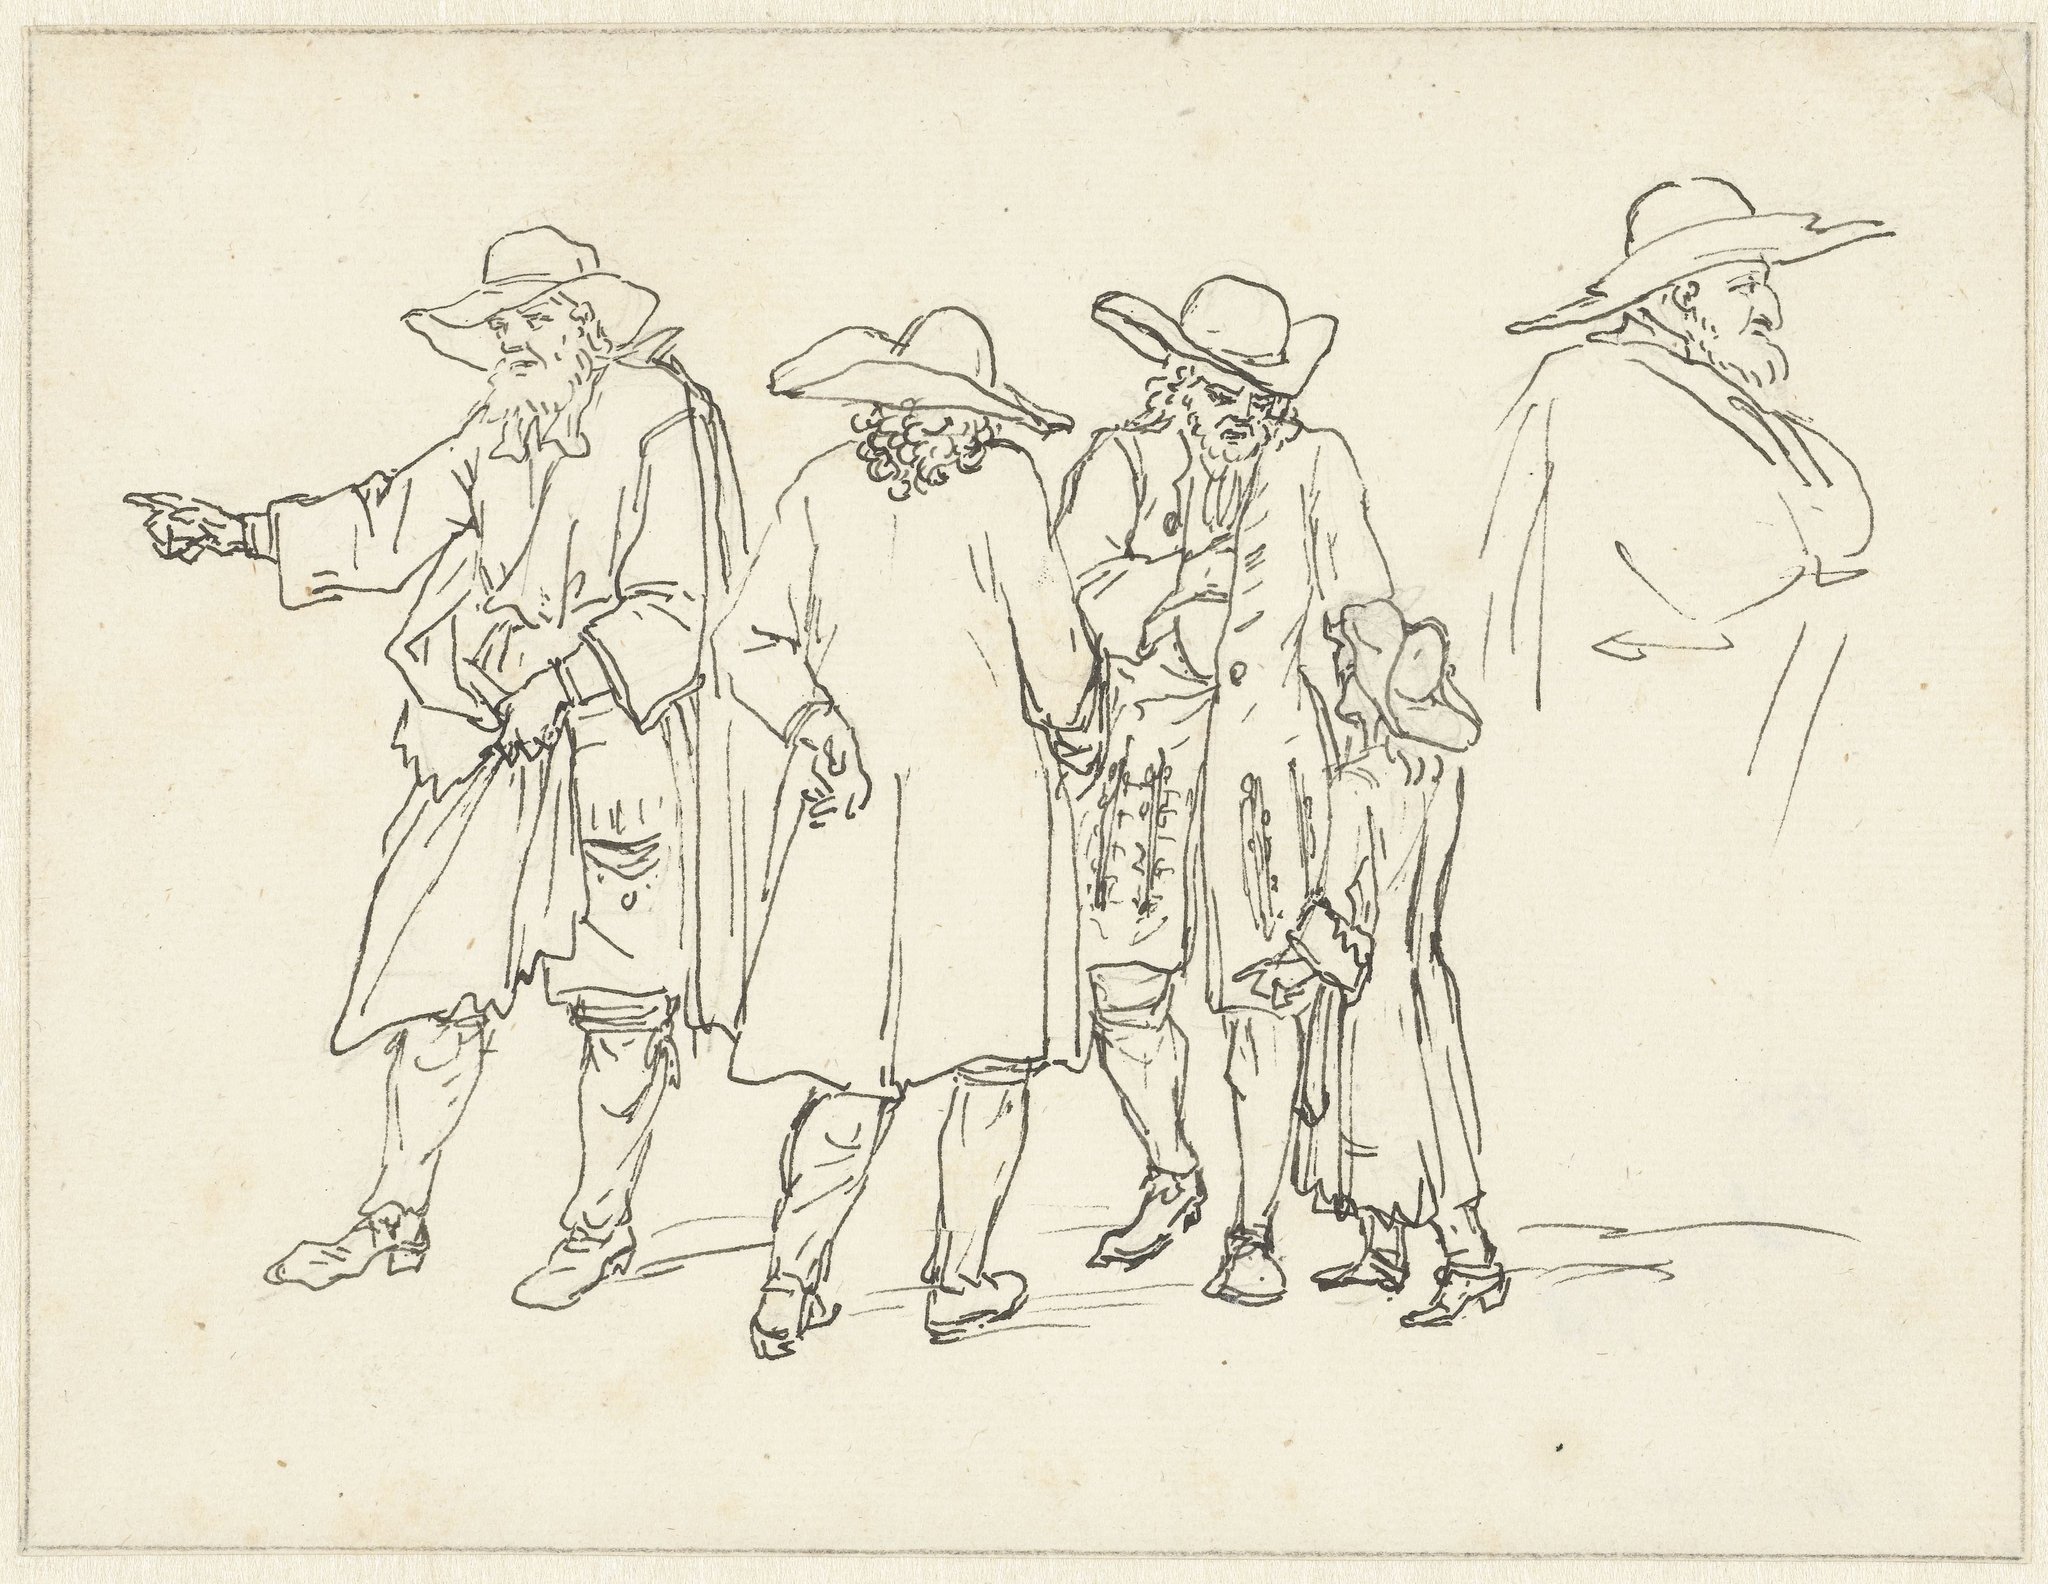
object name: drawing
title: Schetsen van staande mannen met een jongetje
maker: bernard picart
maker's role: draughtsman, print maker, publisher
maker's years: 1673-1733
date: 1683-1733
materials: ink, paper, pencil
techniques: pen